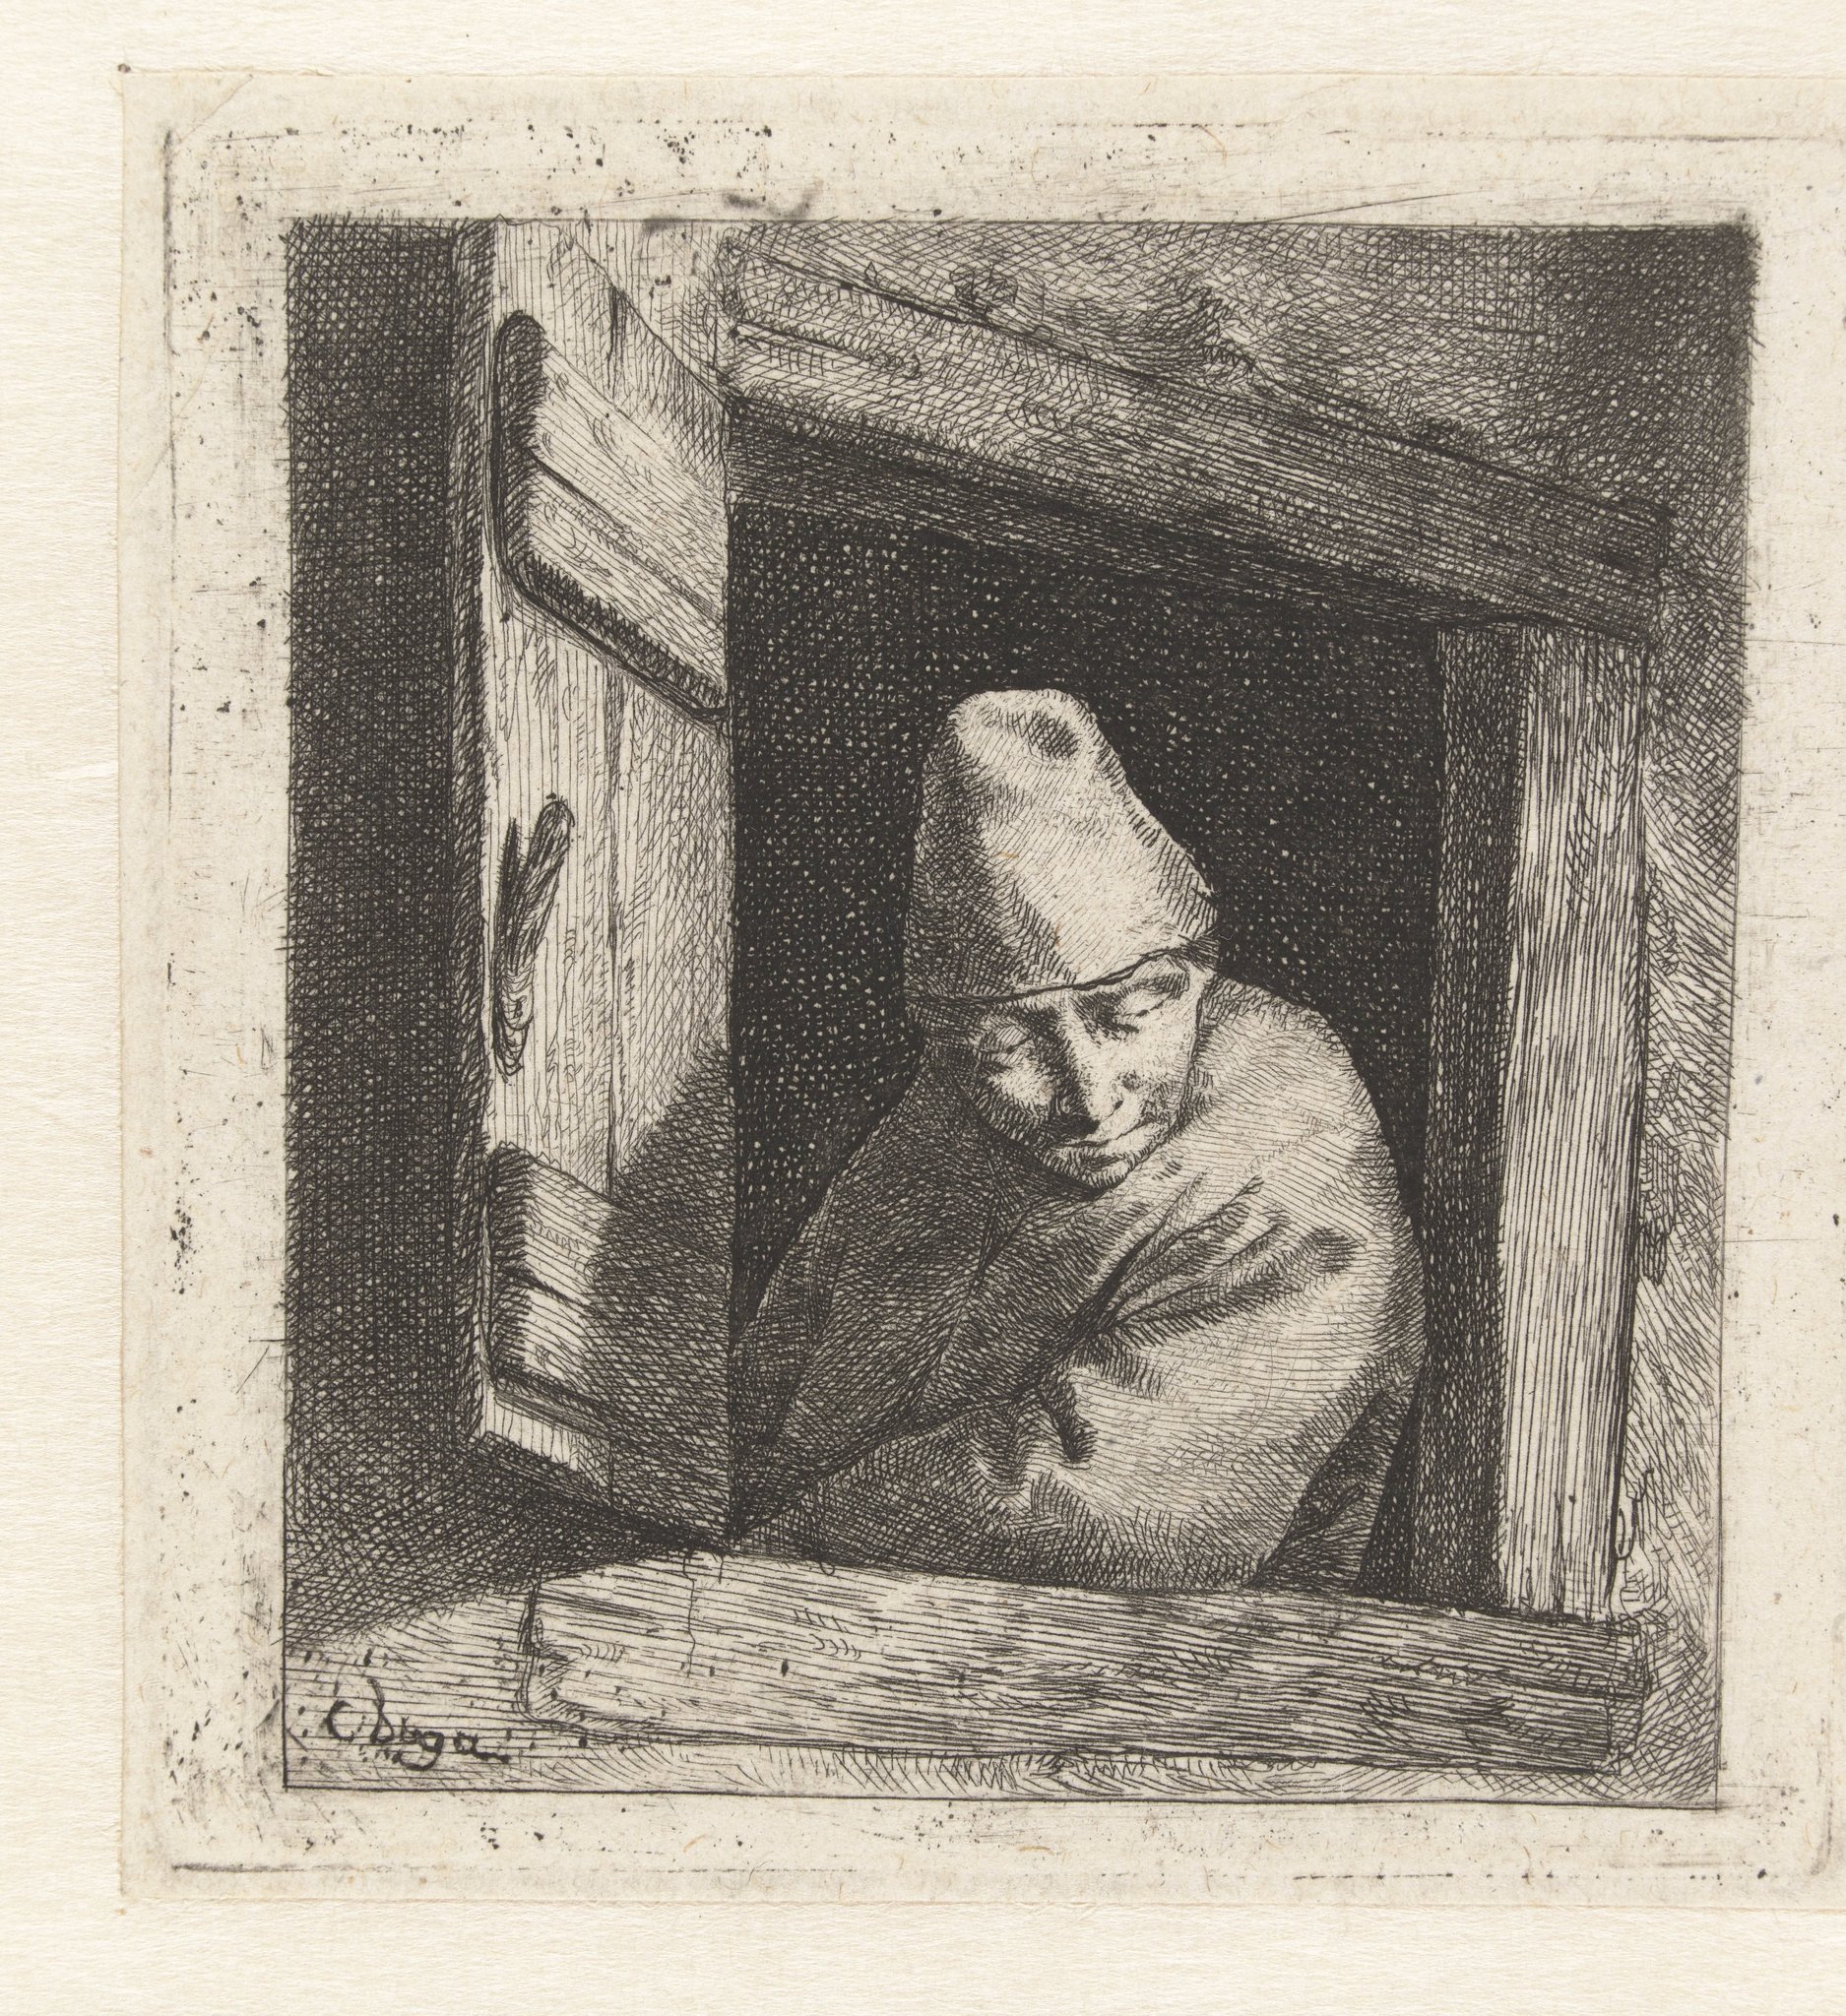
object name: print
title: Man bij open raam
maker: cornelis pietersz. bega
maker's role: draughtsman, painter, print maker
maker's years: 1631-1664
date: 1642-1664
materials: paper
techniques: etching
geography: netherlands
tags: human figure at (open) window, male sex; man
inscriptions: collector's mark: Lugt 2228a